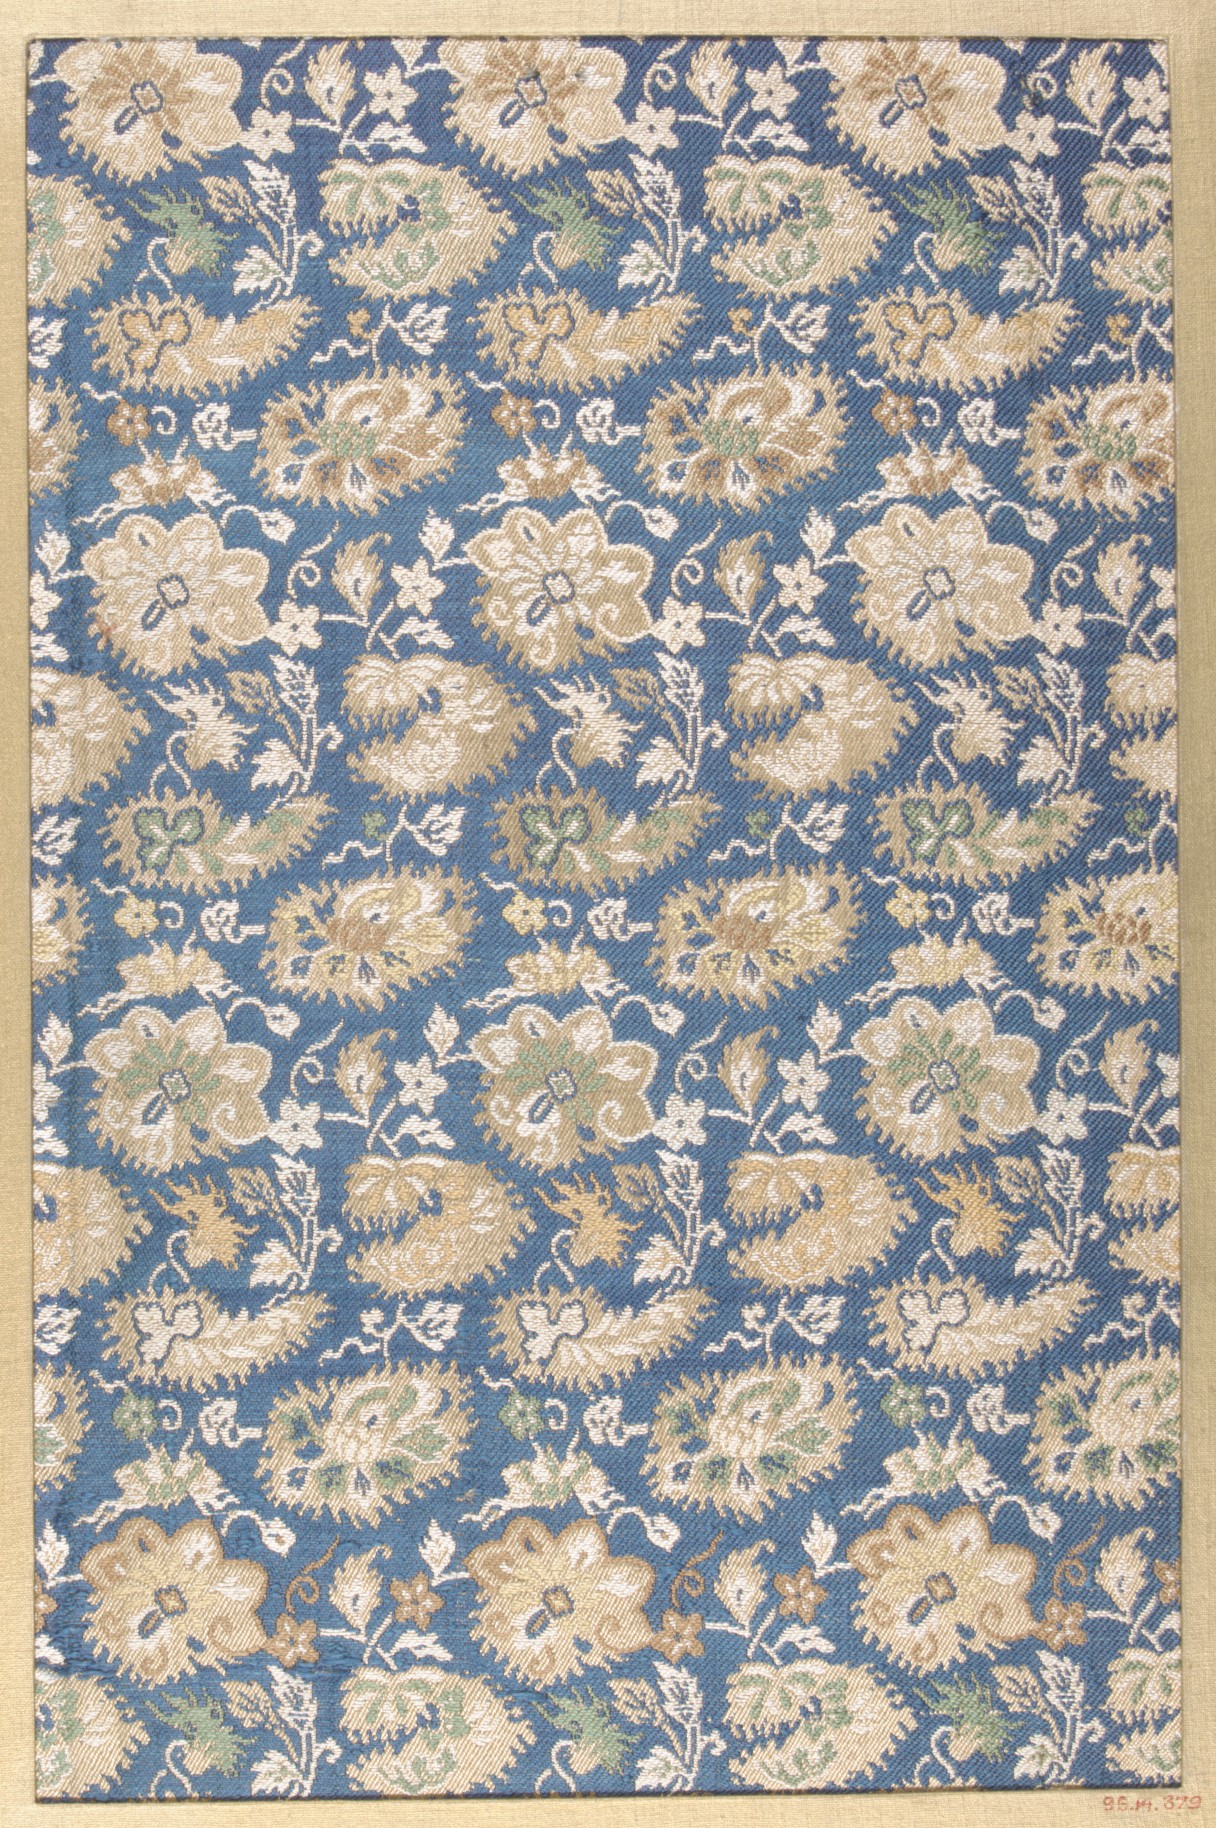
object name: piece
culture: japanese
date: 1701-1900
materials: silk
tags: leaves